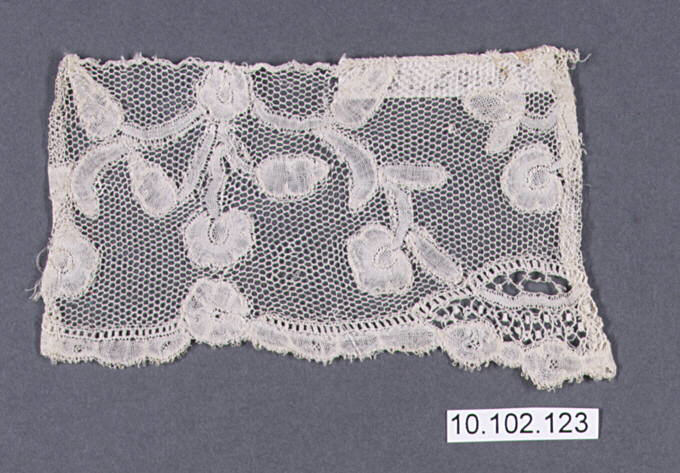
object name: fragment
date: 1701-1800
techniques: lace